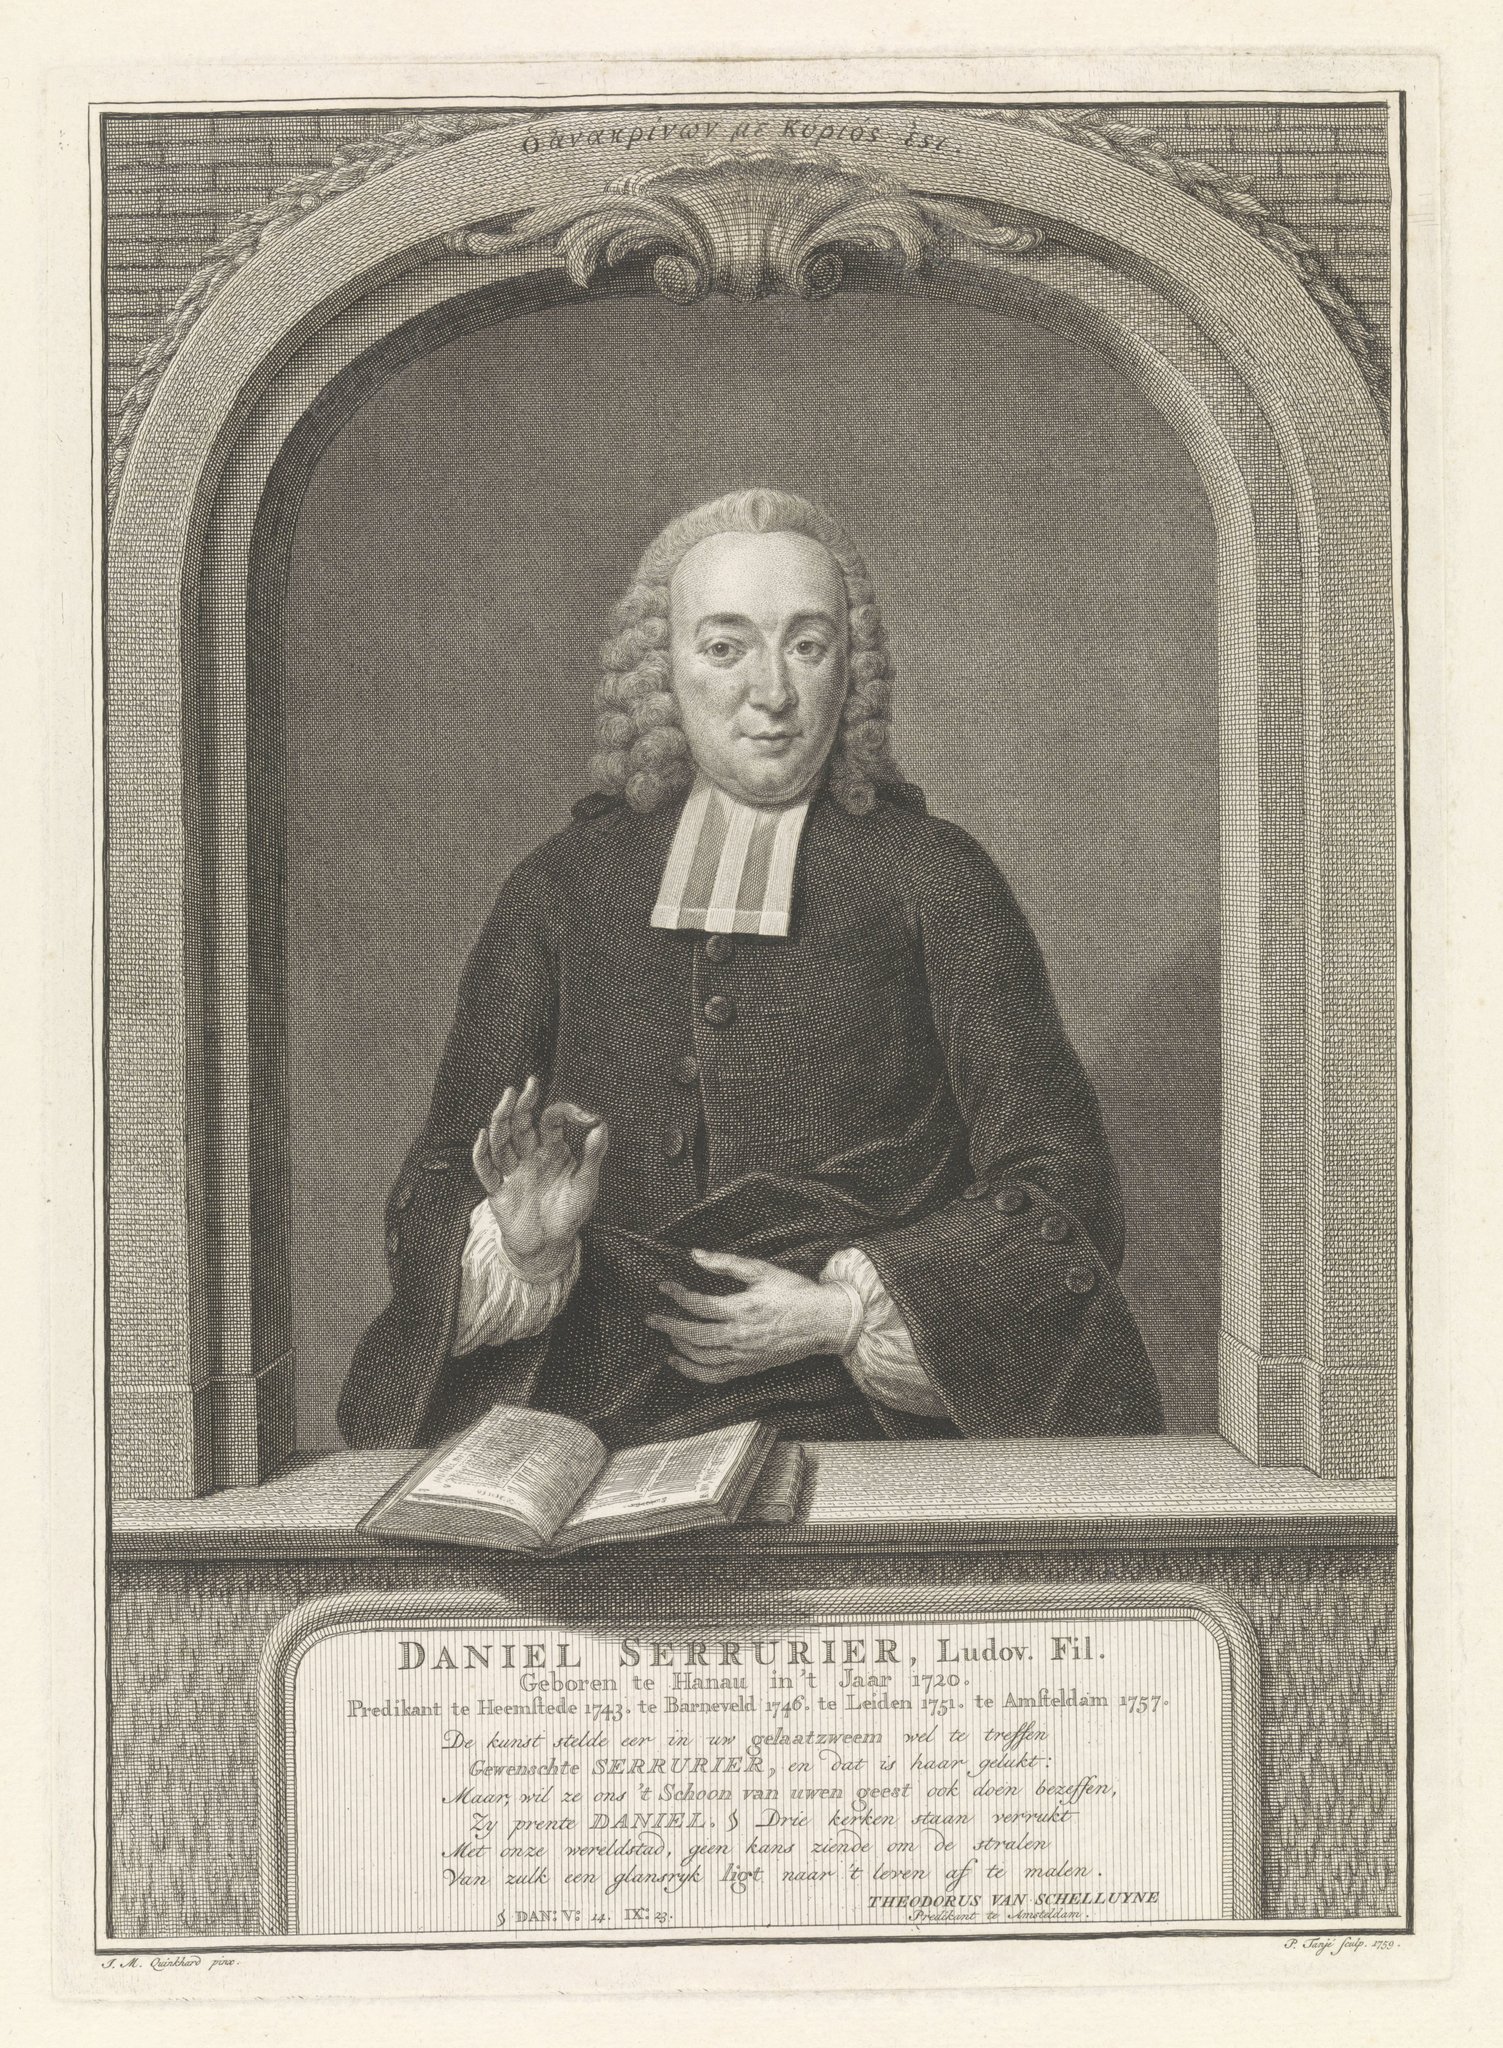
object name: print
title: Portret van Daniel Serrurier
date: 1759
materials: paper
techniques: engraving, etching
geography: amsterdam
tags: leiden, the bible as a book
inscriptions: collector's mark: Lugt 2228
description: Daniel Serrurier, predikant te Heemstede, Barneveld, Leiden en Amsterdam, staande in een venster bij een opengeslagen Bijbel.